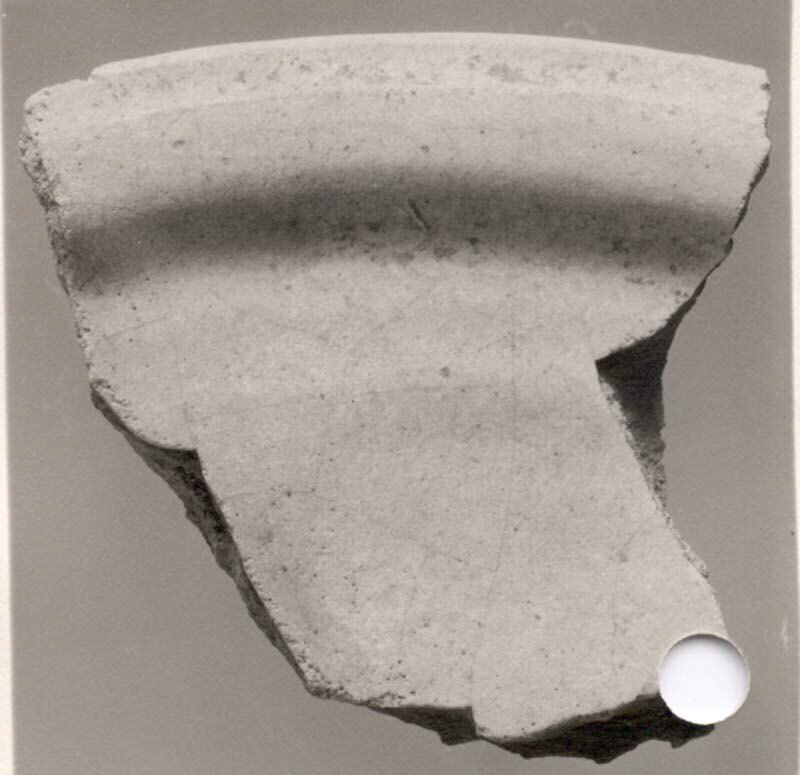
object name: dish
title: Dish fragment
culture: sasanian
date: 201-700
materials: ceramic, glaze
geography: mesopotamia